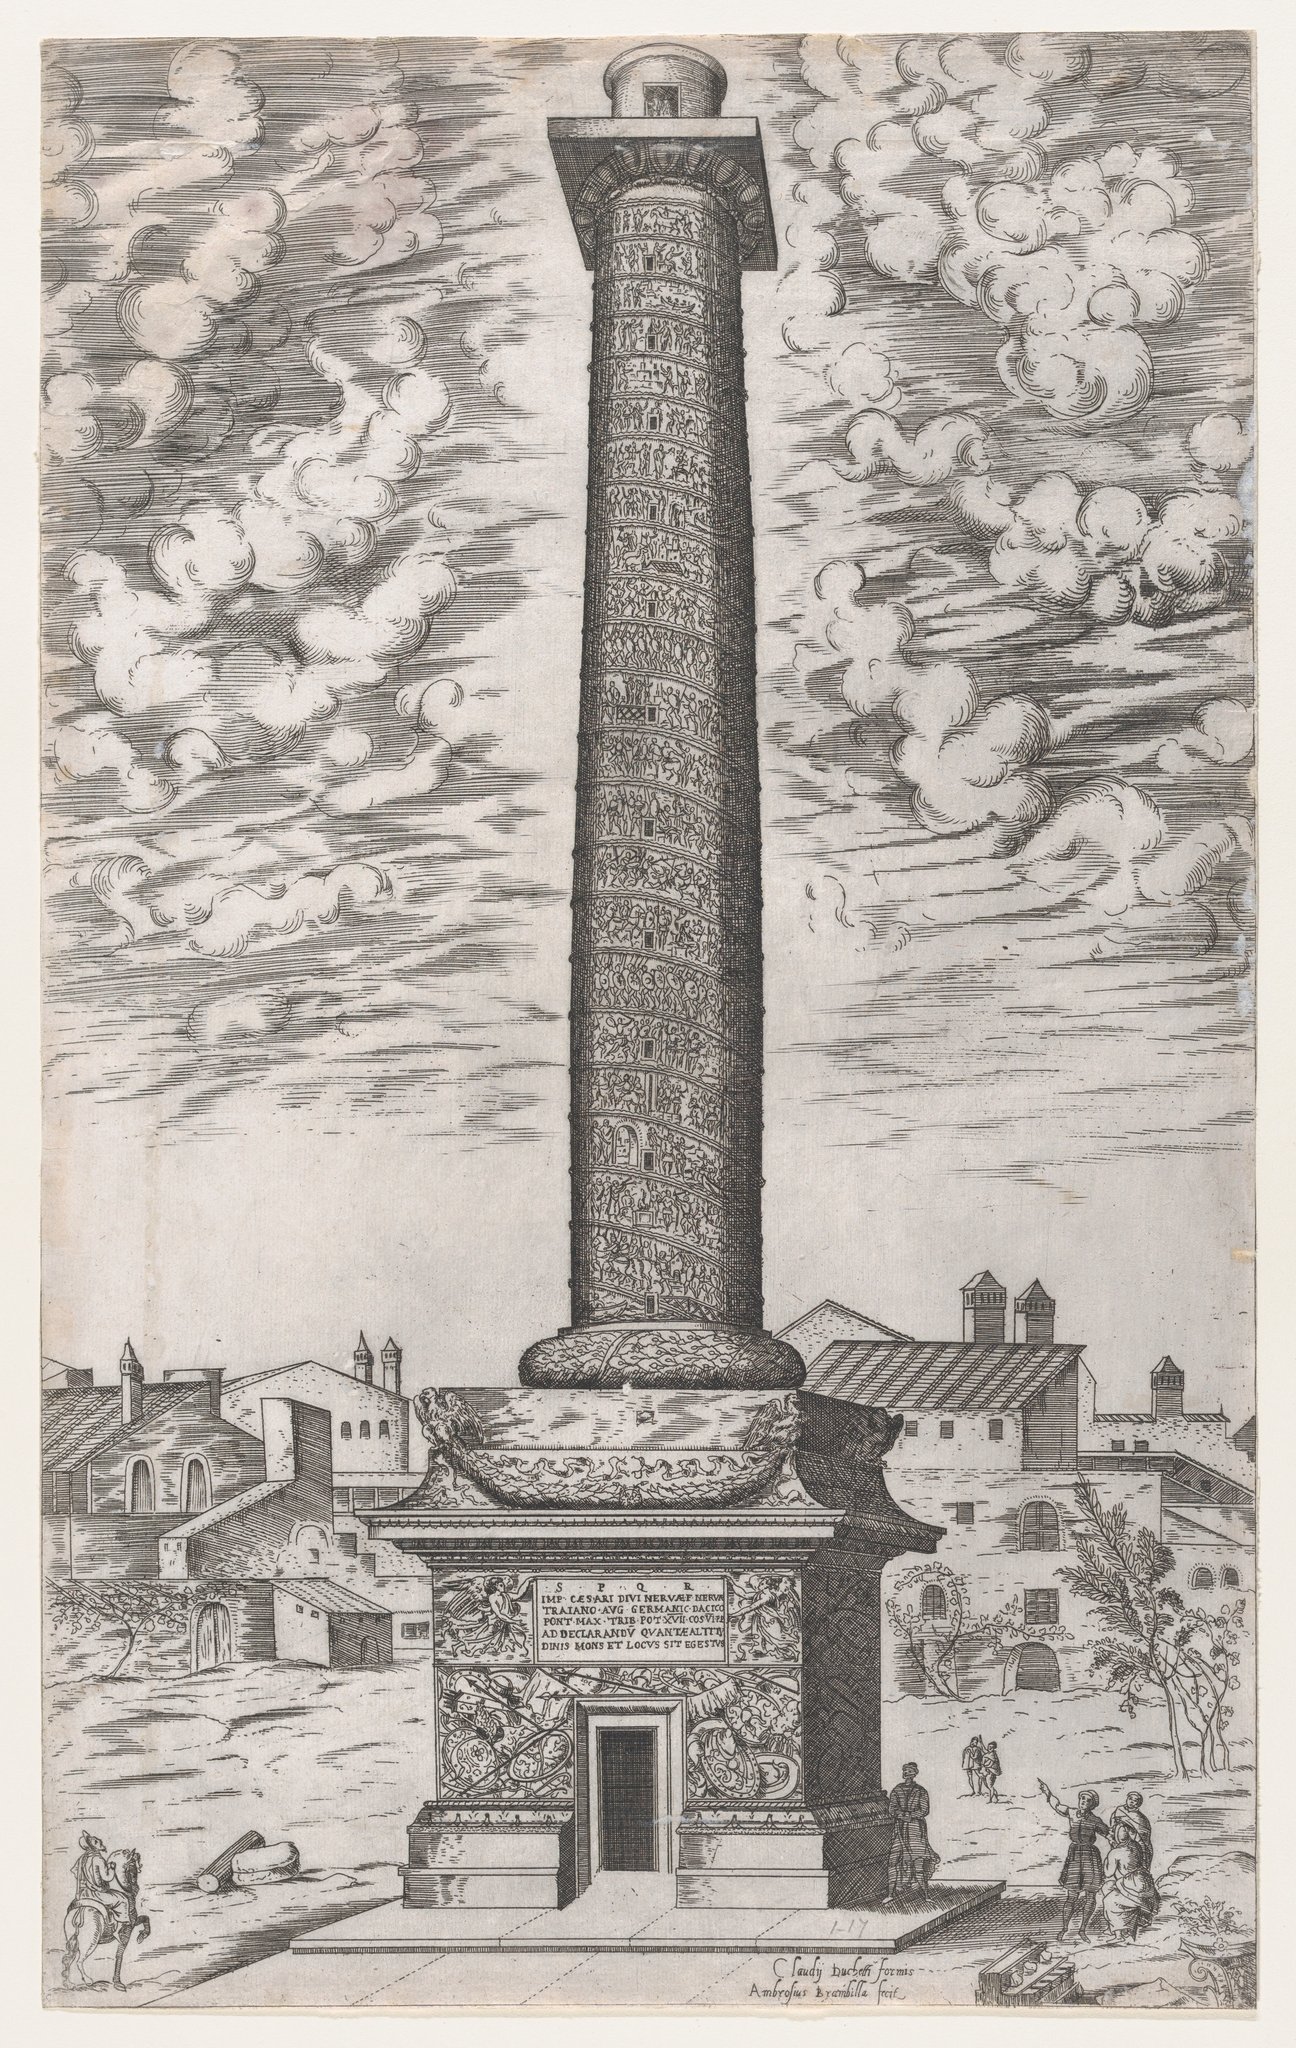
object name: print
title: Trajan's Column, from "Speculum Romanae Magnificentiae"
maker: giovanni ambrogio brambilla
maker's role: artist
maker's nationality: italian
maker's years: 1575-1599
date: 1581-1586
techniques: etching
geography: rome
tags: human figures,monuments,horses,rome